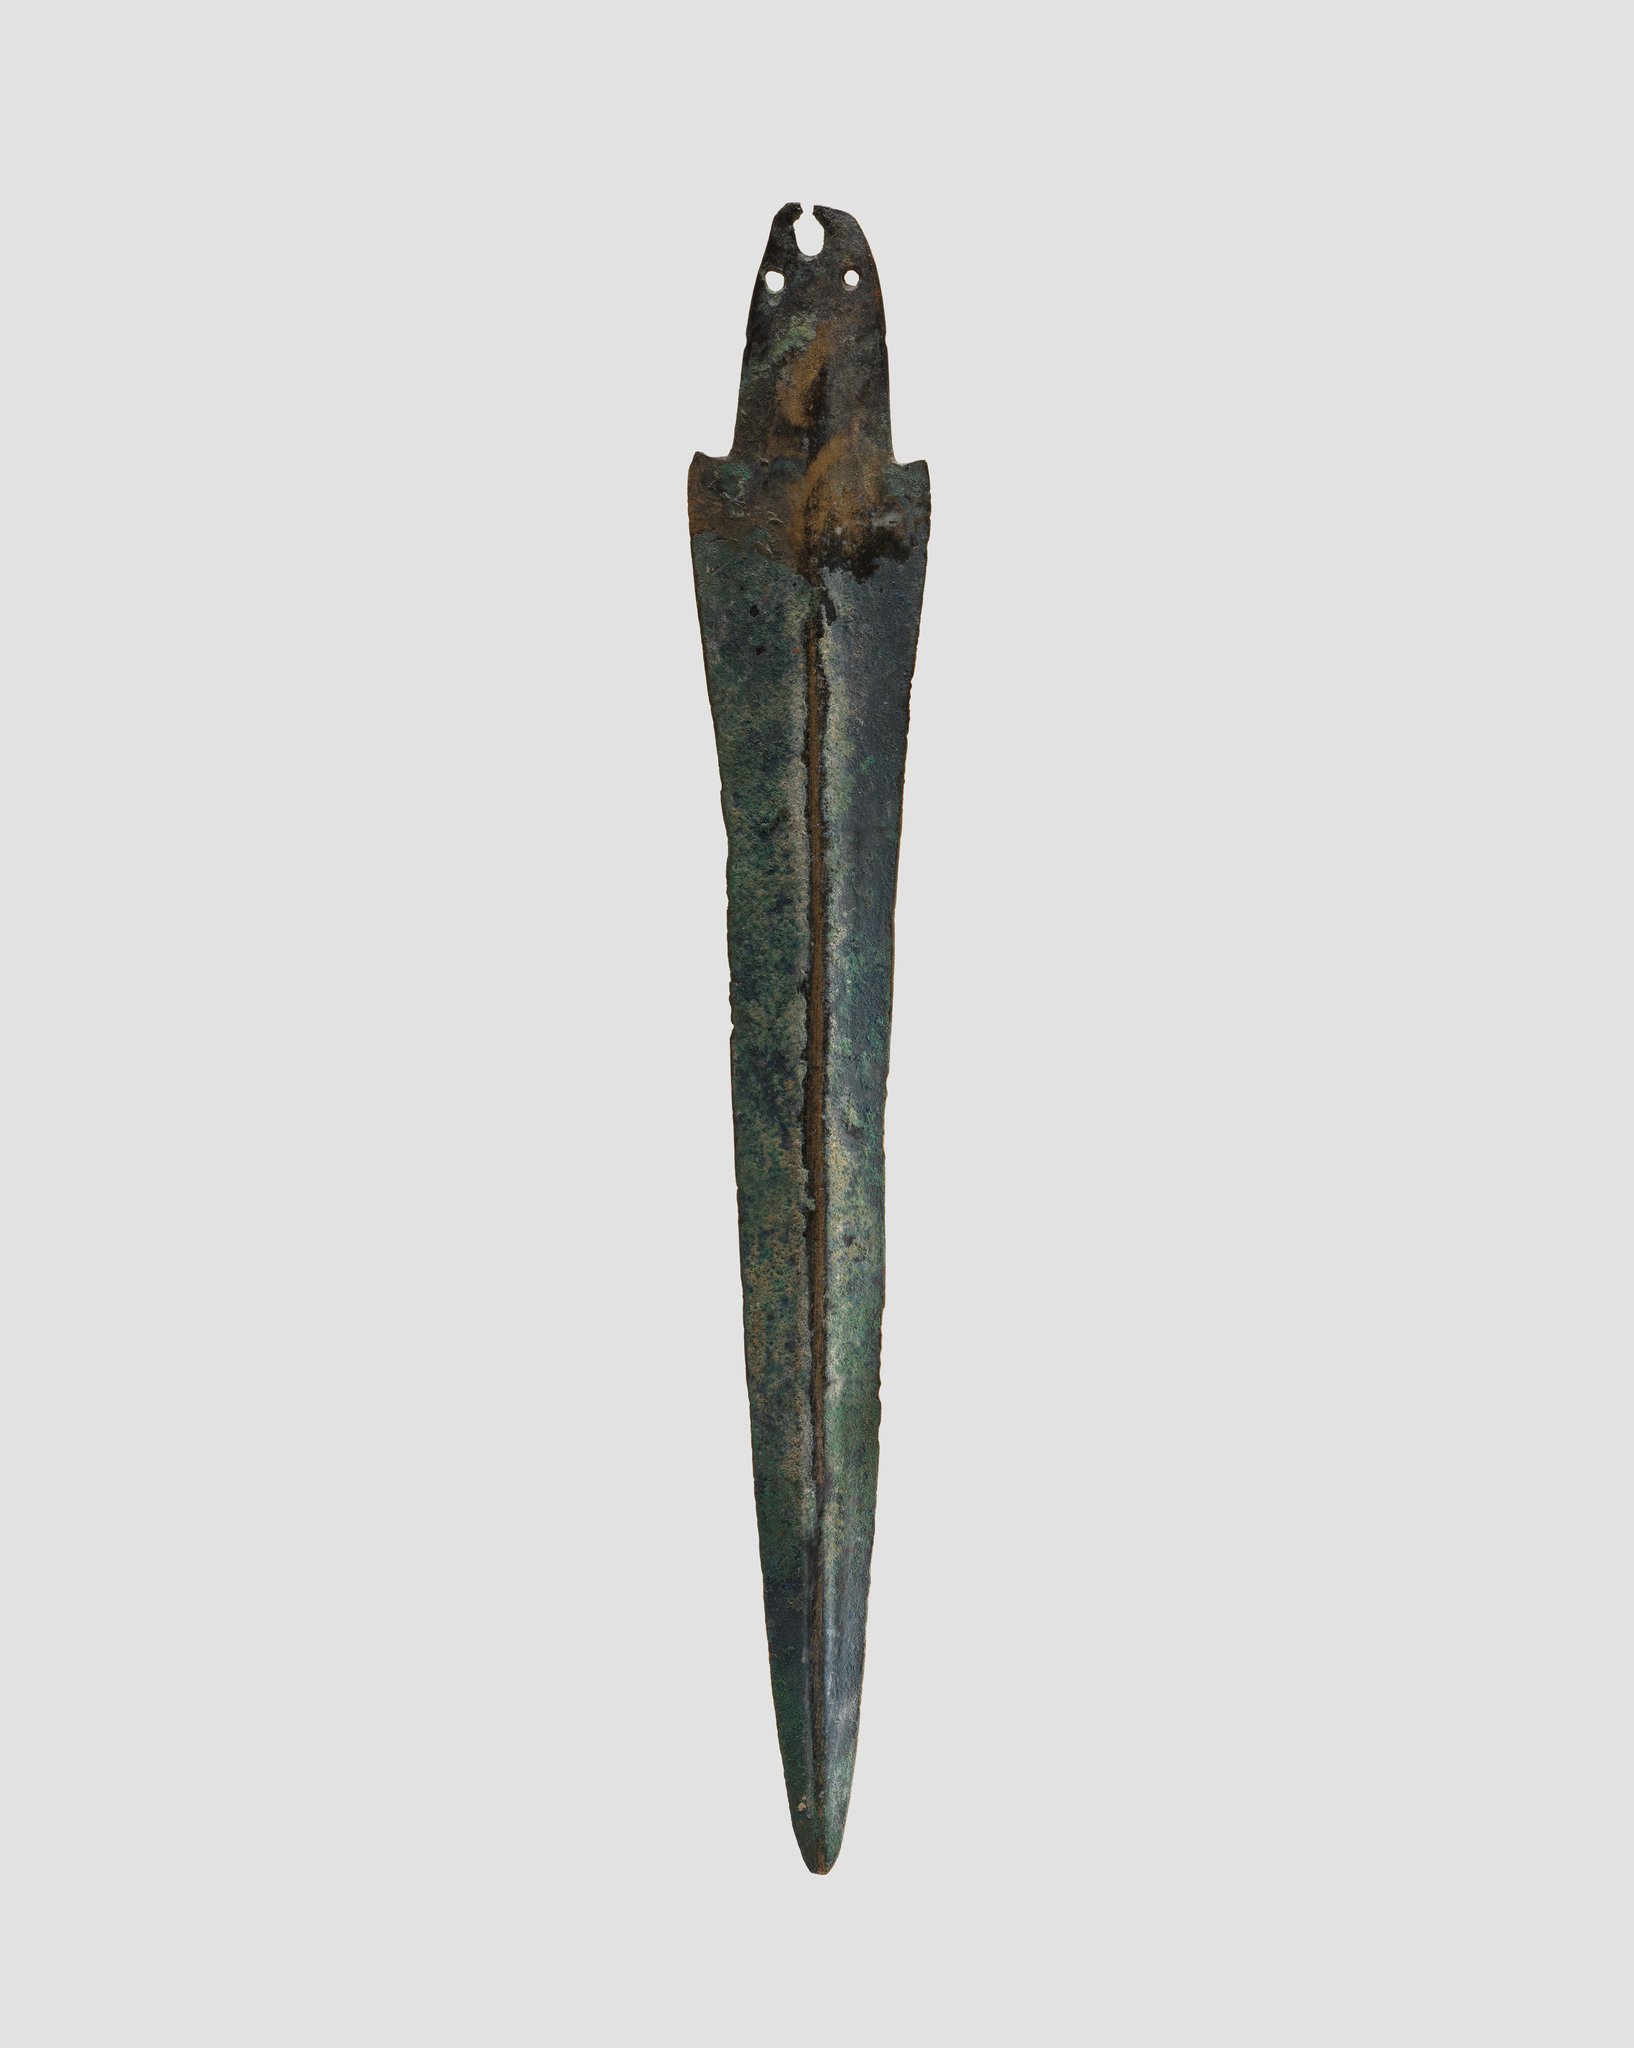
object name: sword or dagger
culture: hattian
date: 2300-2000 BCE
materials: bronze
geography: central anatolia